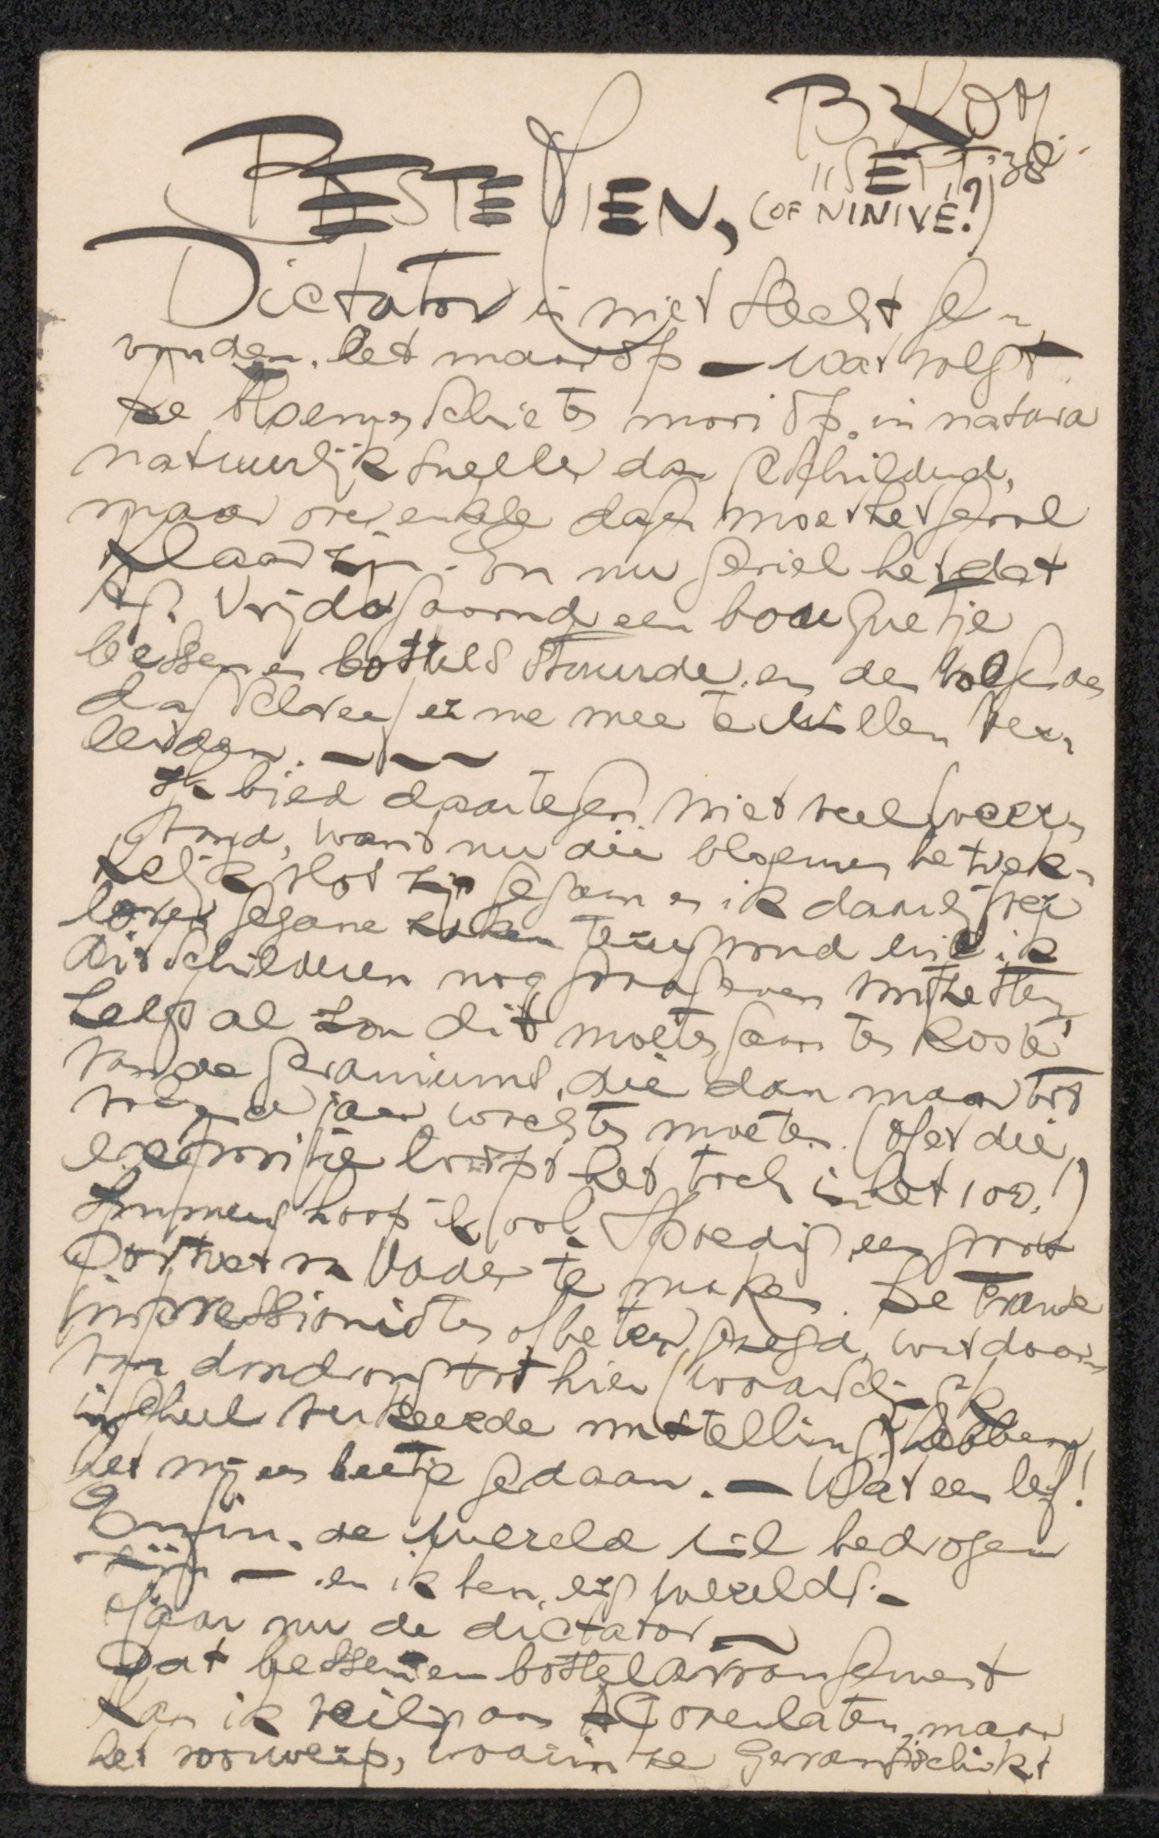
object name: letter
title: Brief aan Mien Cambier van Nooten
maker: dick ket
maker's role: draughtsman, print maker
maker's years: 1902-1940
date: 1938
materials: cardboard, ink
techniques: pen, writing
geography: bennekom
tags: grave, sculptor, arnhem, mien cambier van nooten, painter, jac van looij, johan mekkink, dollmaker, textile artist, nelly johanna hagelen-schilt, painting (including book-illumination, miniature-painting), exhibition ~ art, historical persons (portraits and scenes from the life)